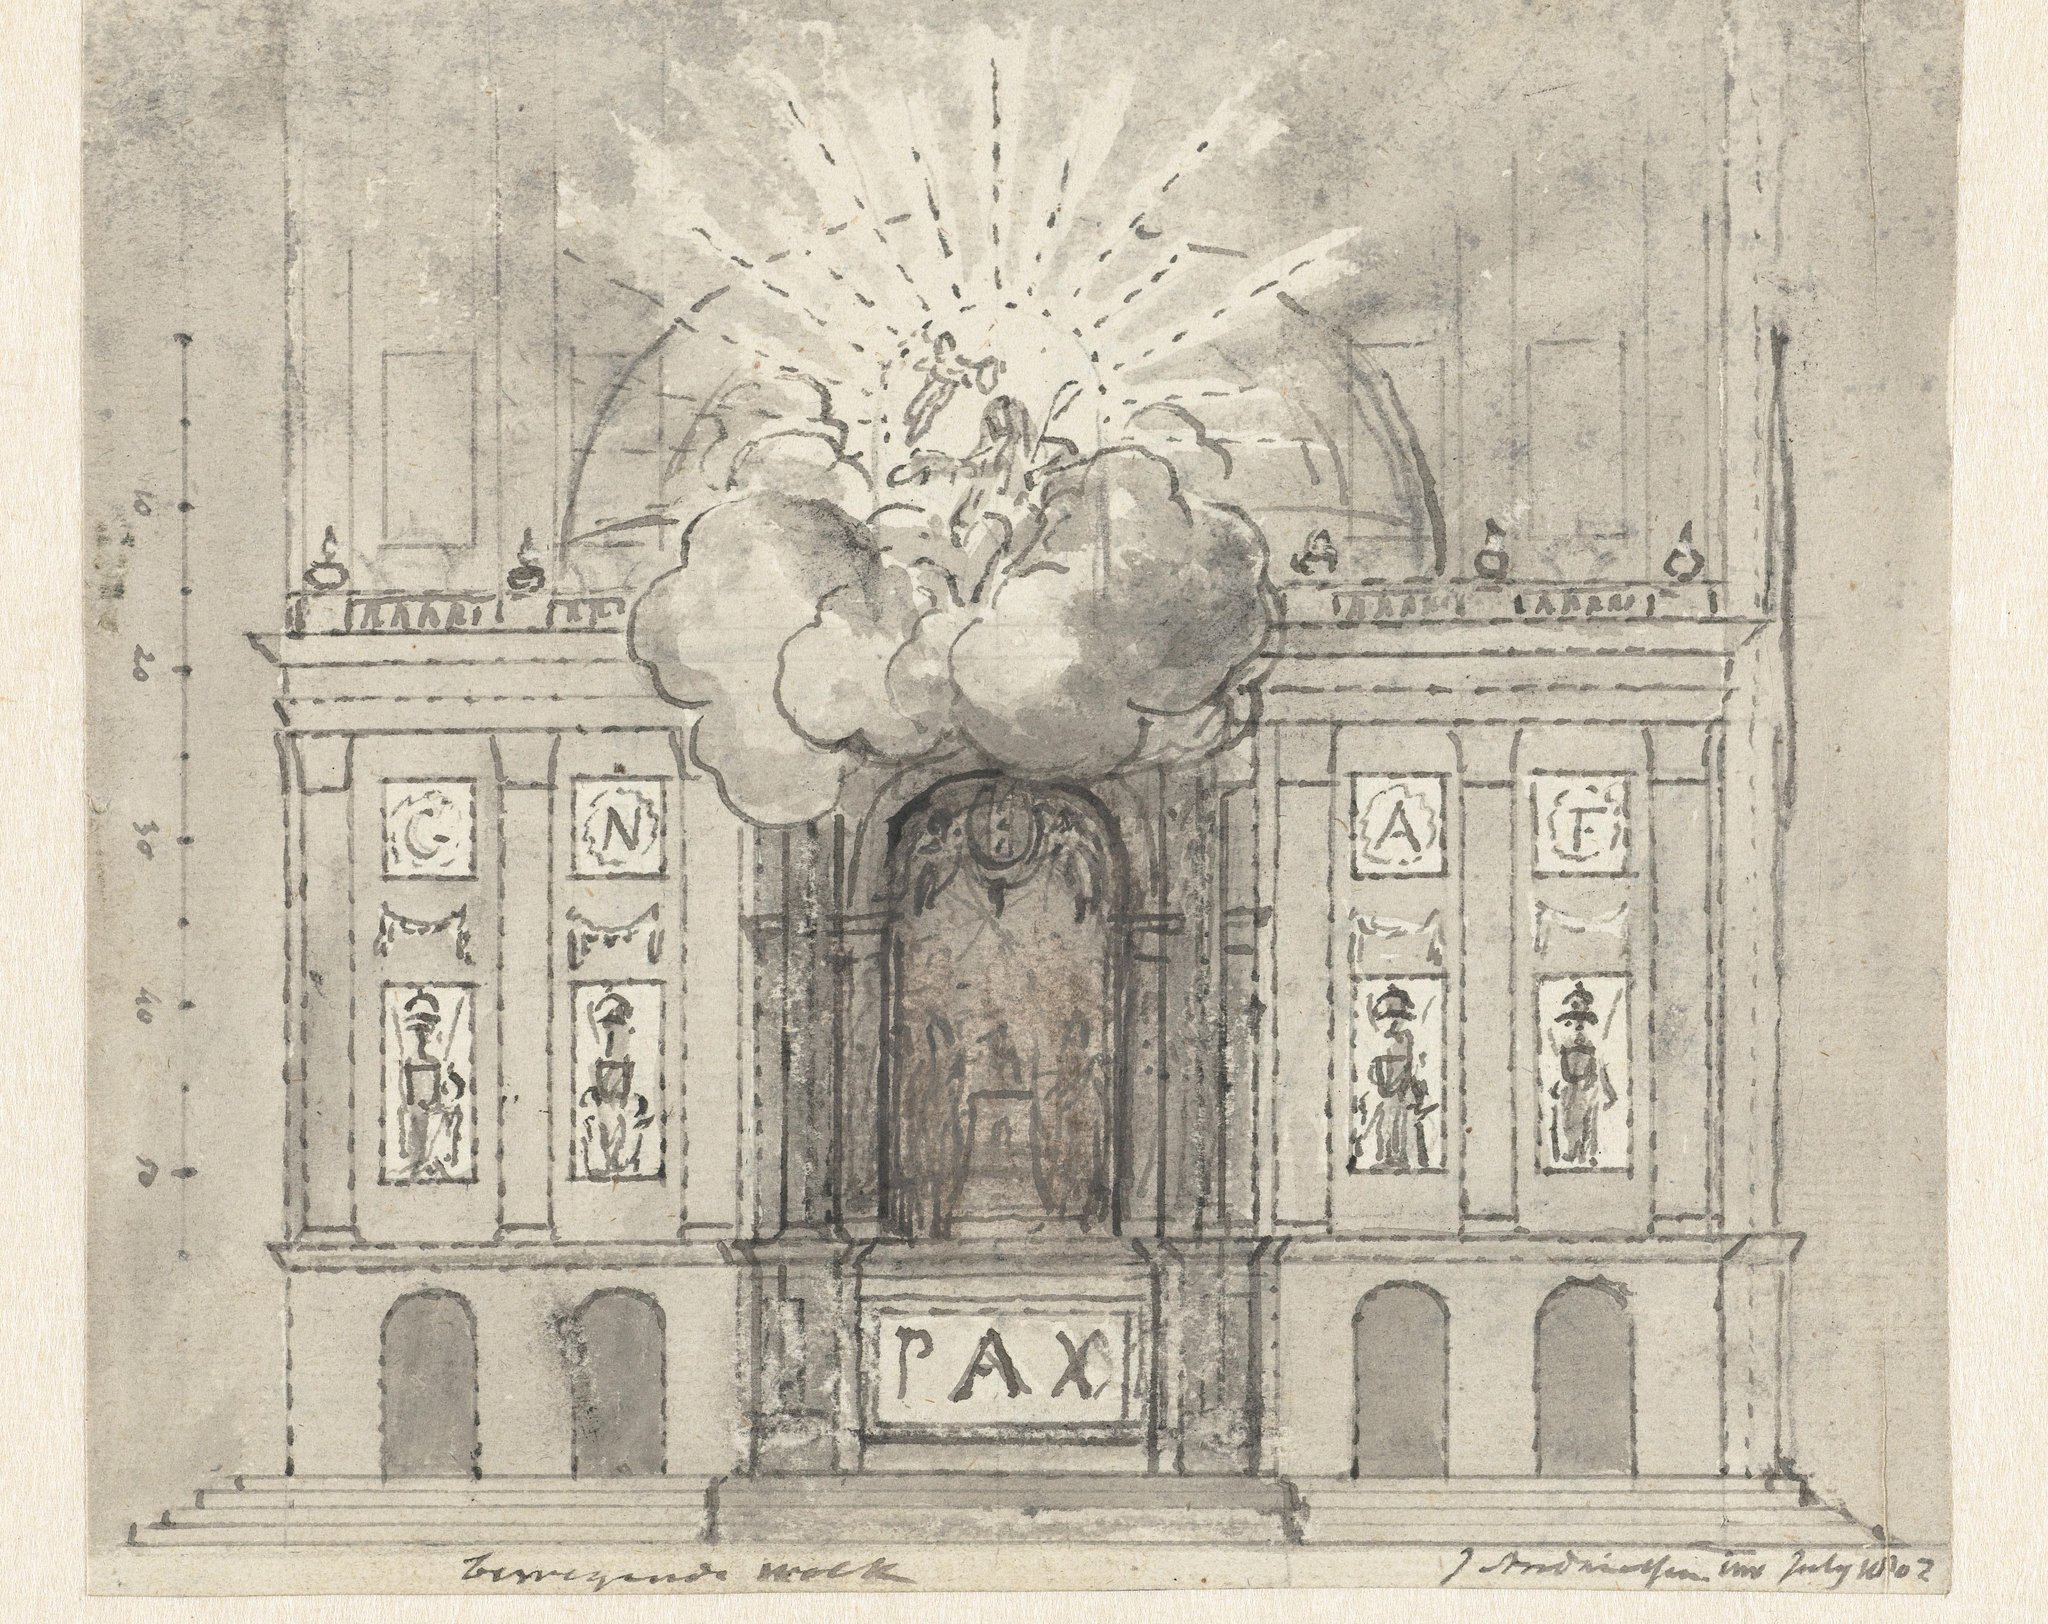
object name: drawing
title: Ontwerp voor een decoratie op het gebouw van Felix Meritis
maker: jurriaan andriessen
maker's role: draughtsman, painter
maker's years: 1742-1819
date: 1802-1807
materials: graphite, ink, paper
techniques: brush, pen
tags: symbols, allegories of peace, 'pax'; 'pace' (ripa), proclamation of peace, festivities on events of national importance, historical events and situations, amsterdam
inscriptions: date: ‘July 1802’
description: Ontwerp voor een decoratie, t.g.v. "Pax", op het gebouw van Felix Meritis te Amsterdam, juli 1802.